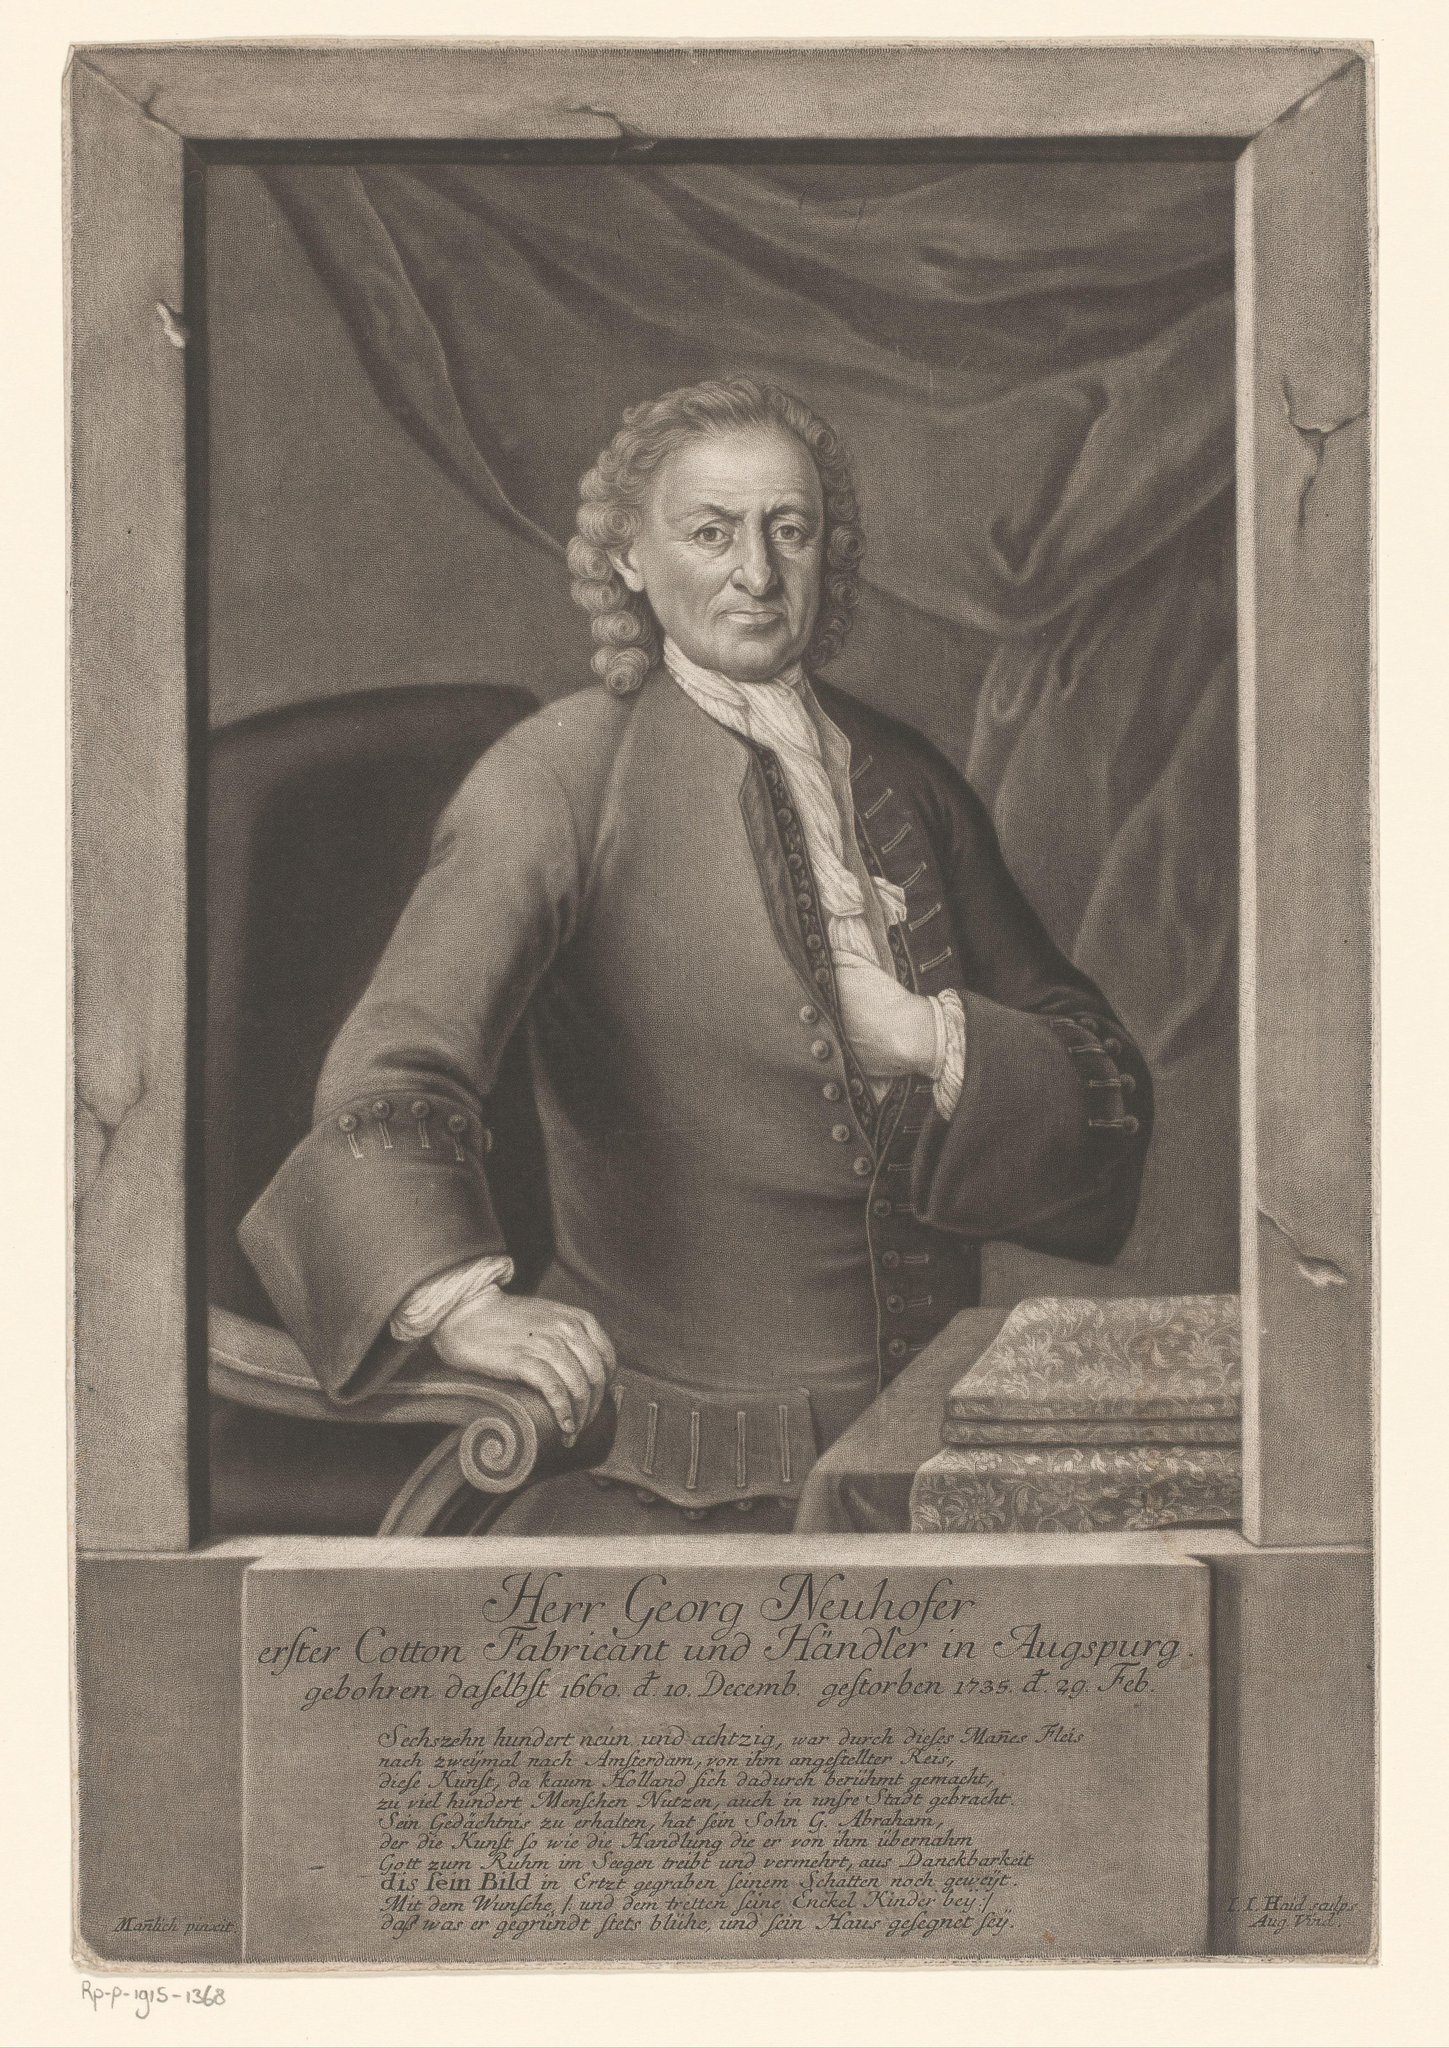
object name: print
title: Portret van Georg Neuhofer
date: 1735-1767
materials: paper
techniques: mezzotint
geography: augsburg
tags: historical persons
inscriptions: collector's mark: Lugt 2228